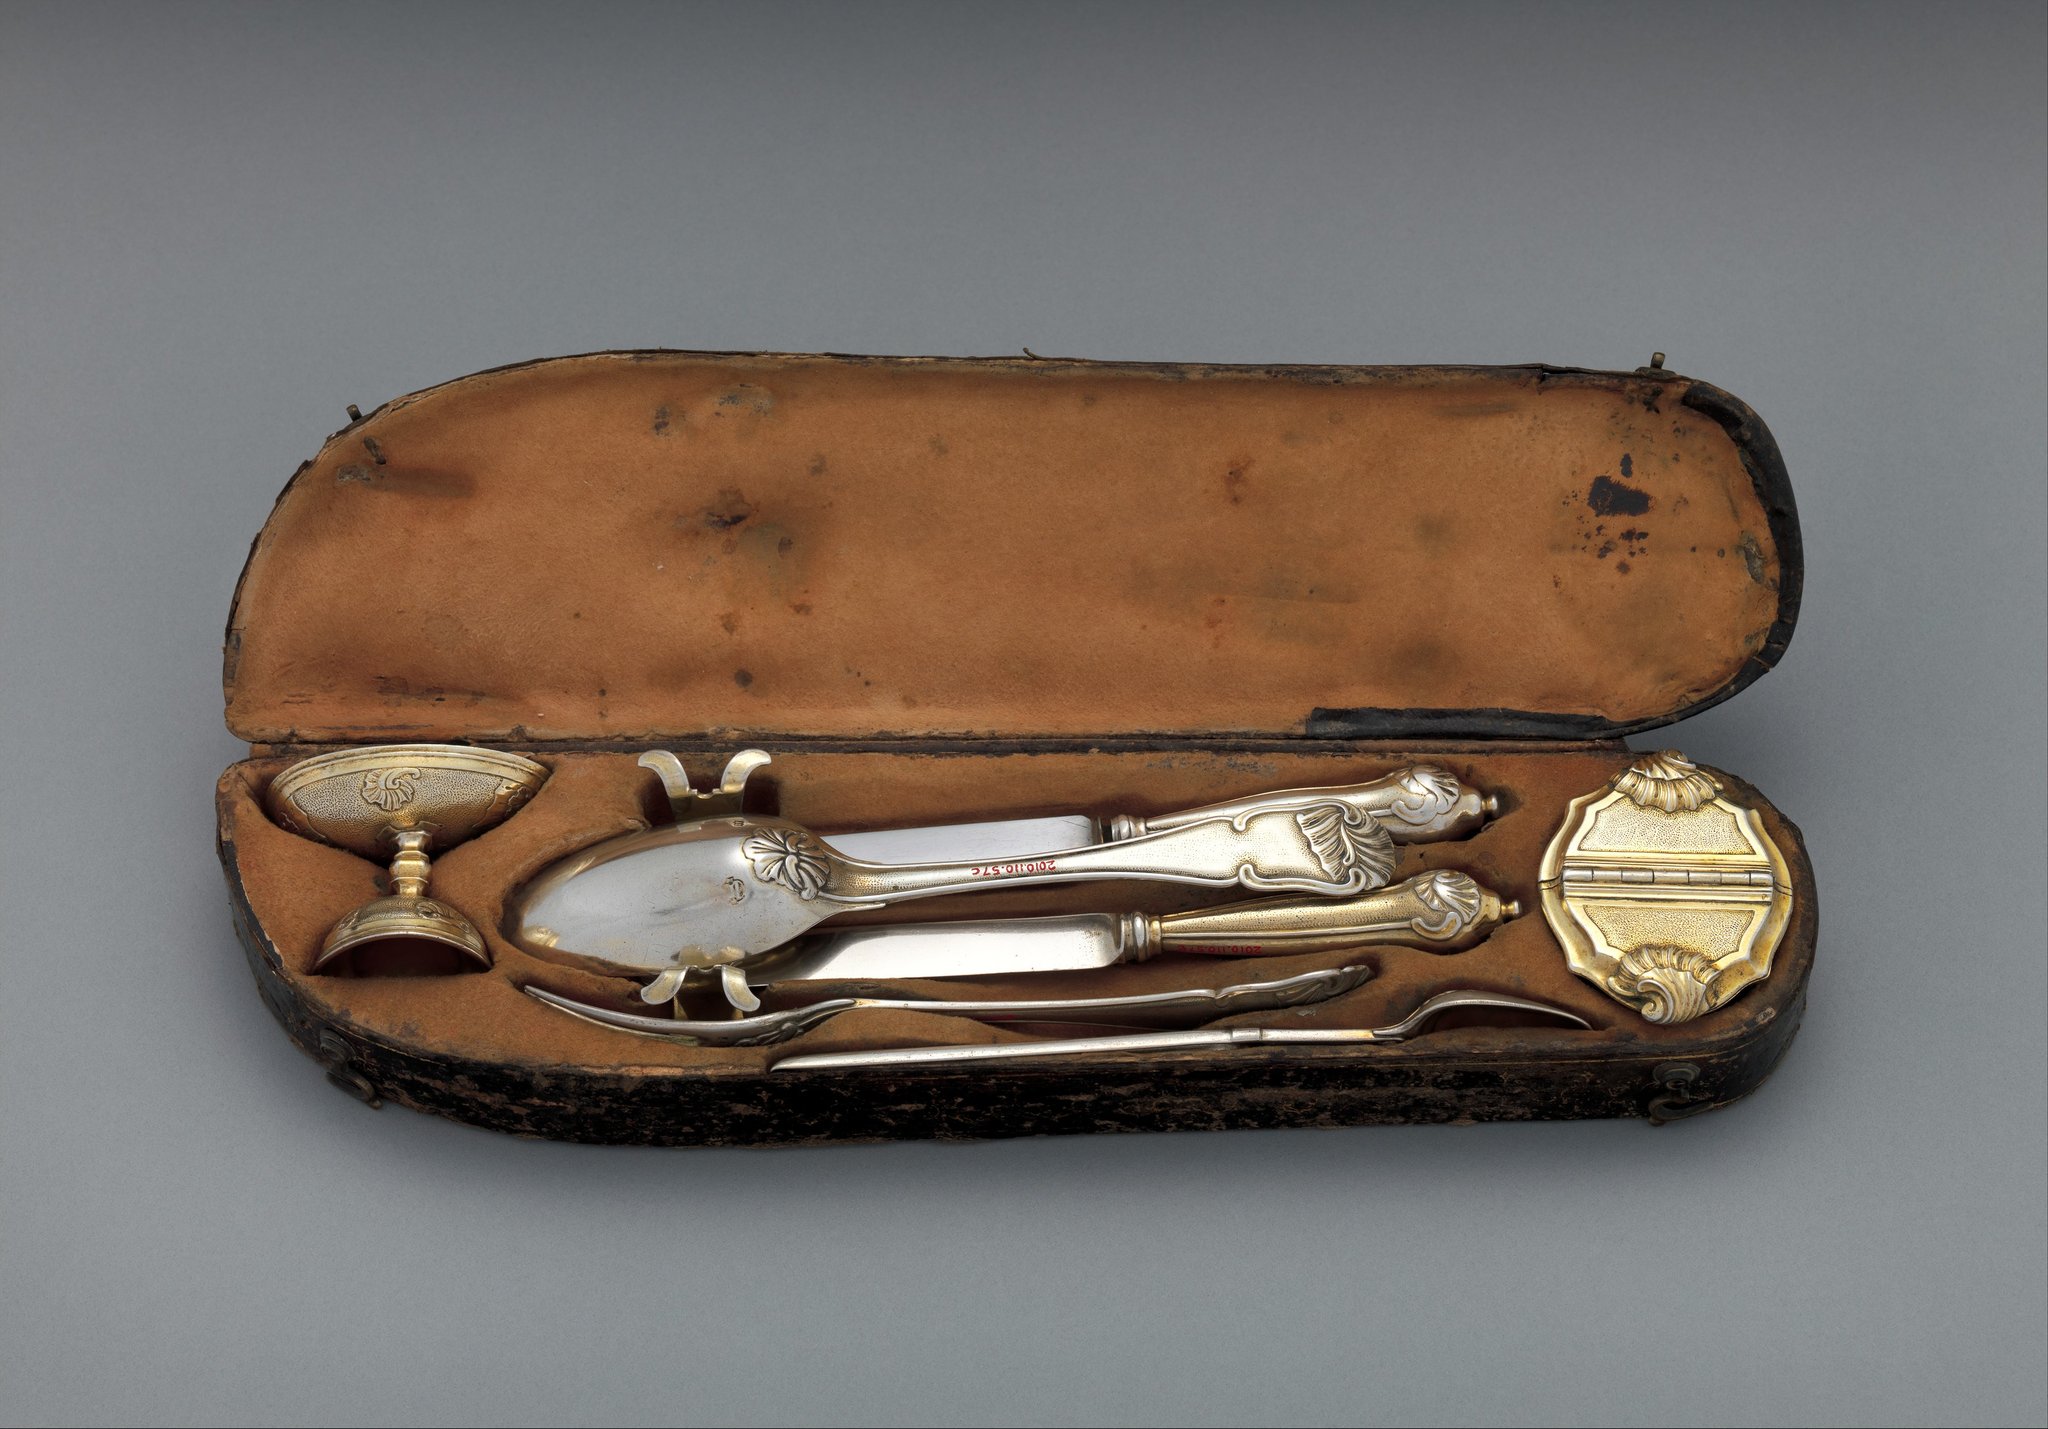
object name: traveling set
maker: i.f.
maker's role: maker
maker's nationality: hungarian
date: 1760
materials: leather, silver, steel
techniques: gilding, tooling